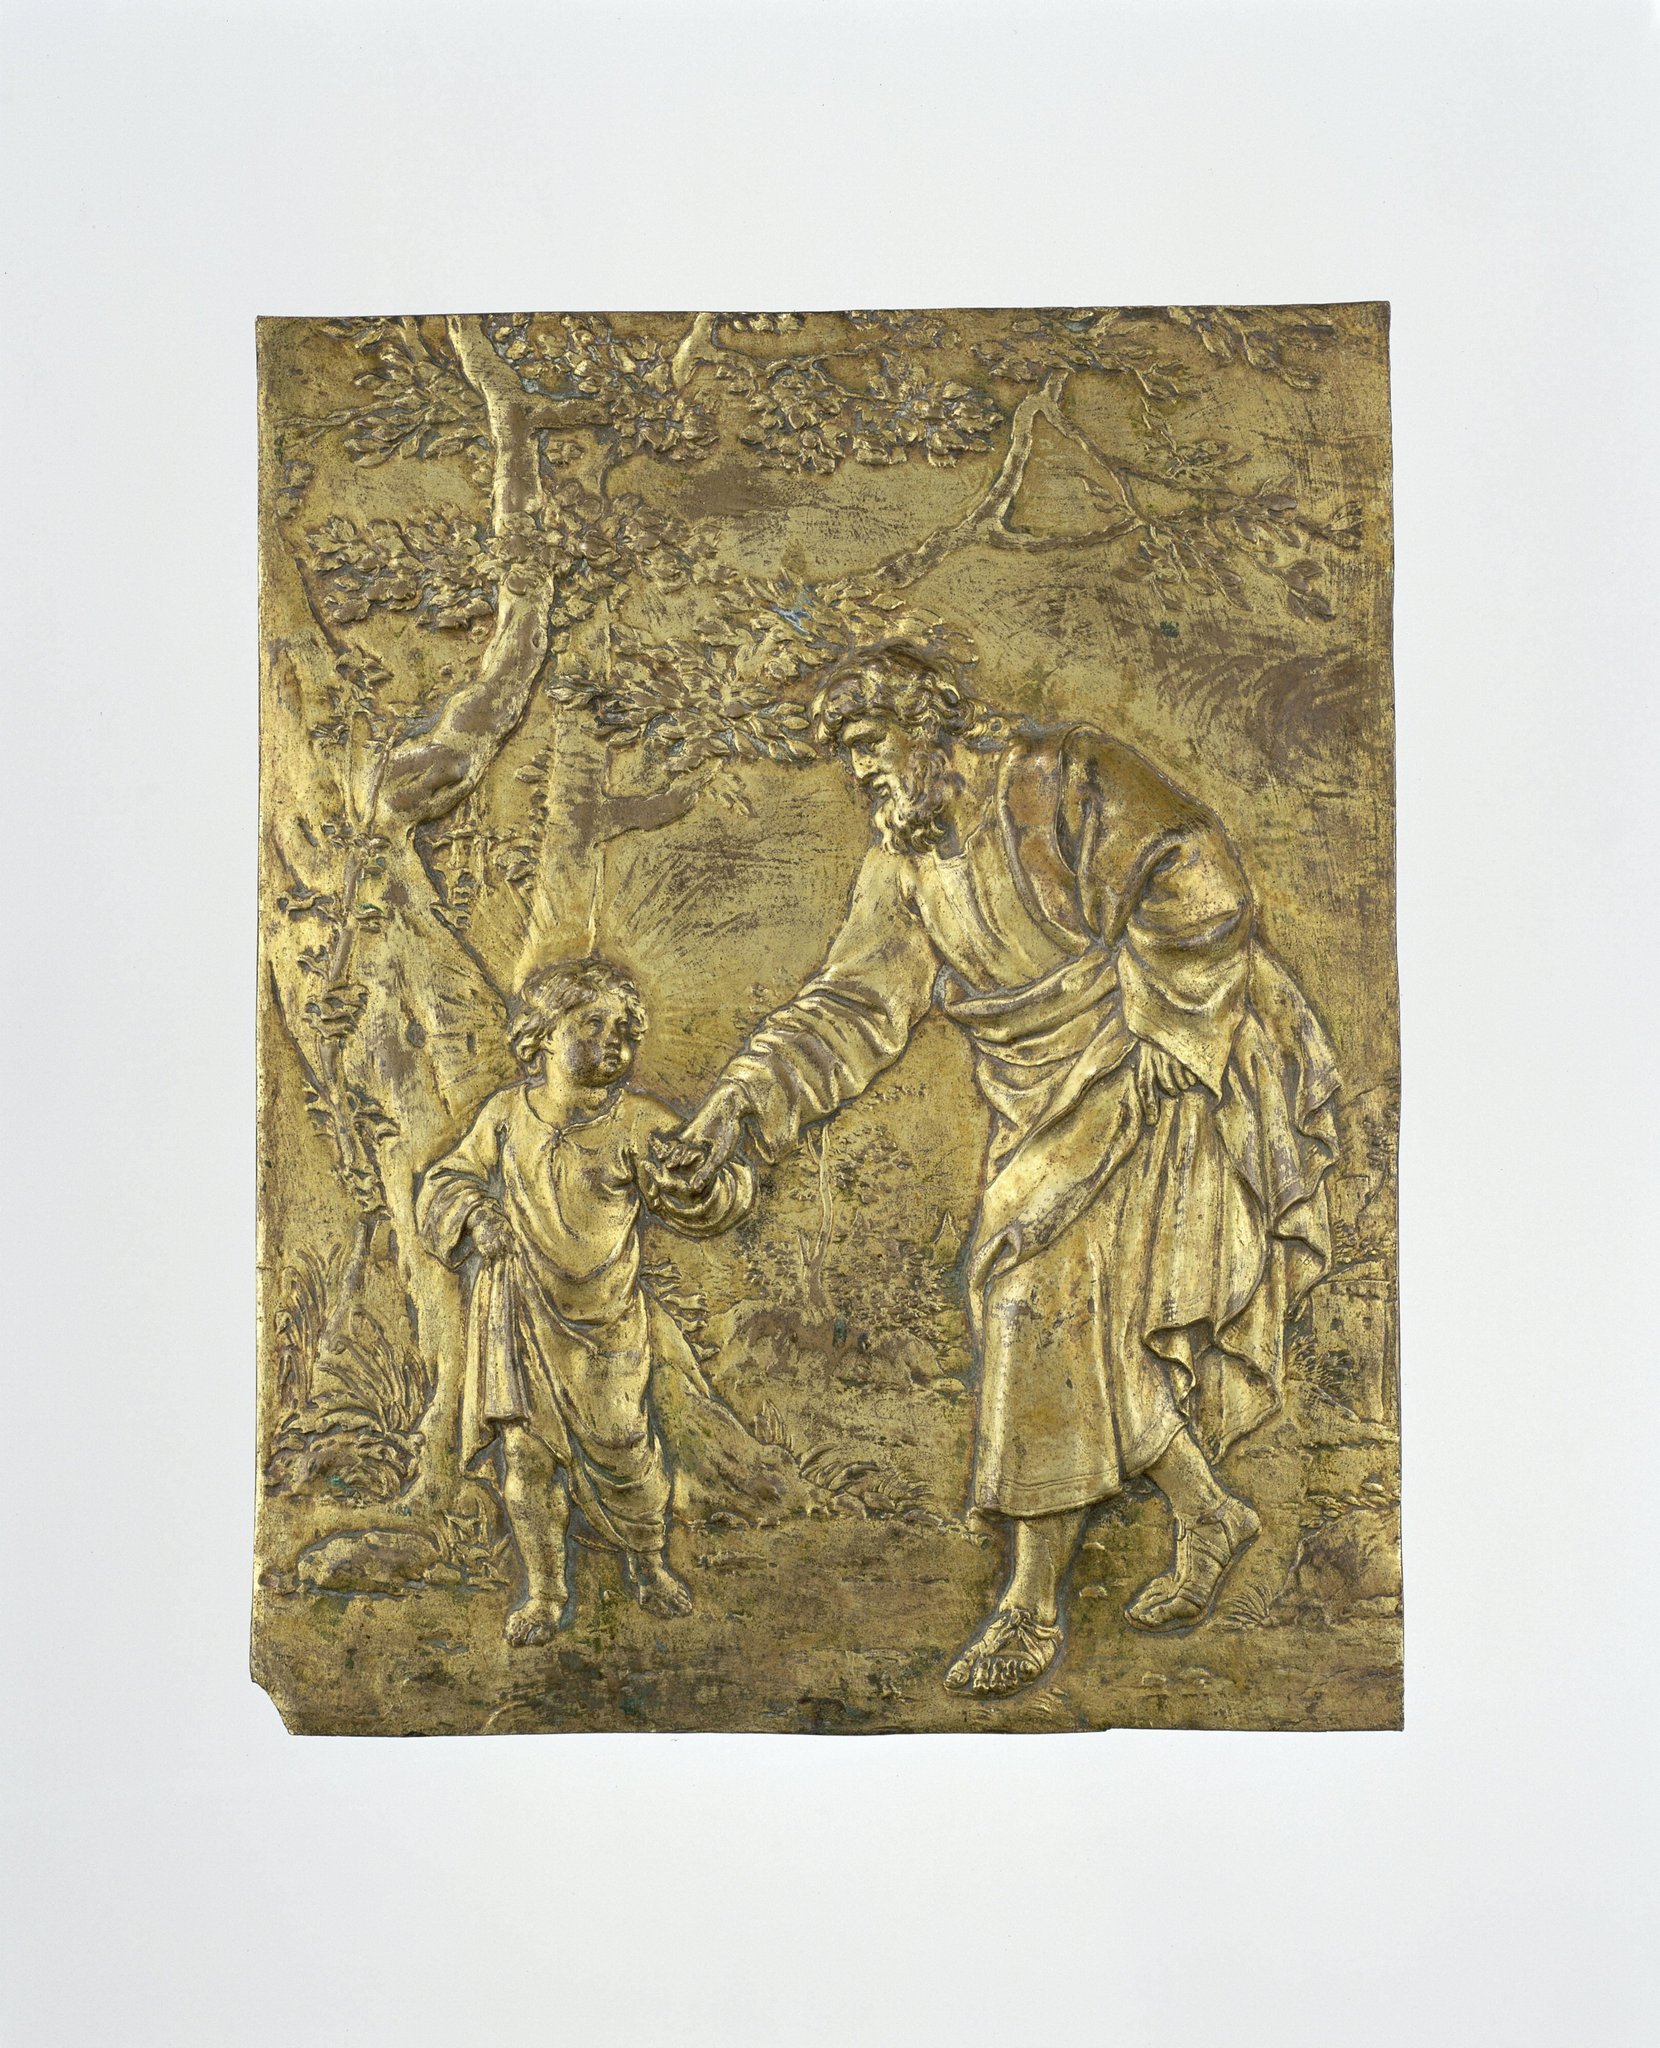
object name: plaque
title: Jozef met kind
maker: Anonymous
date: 1644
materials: bronze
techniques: gilding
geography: southern germany